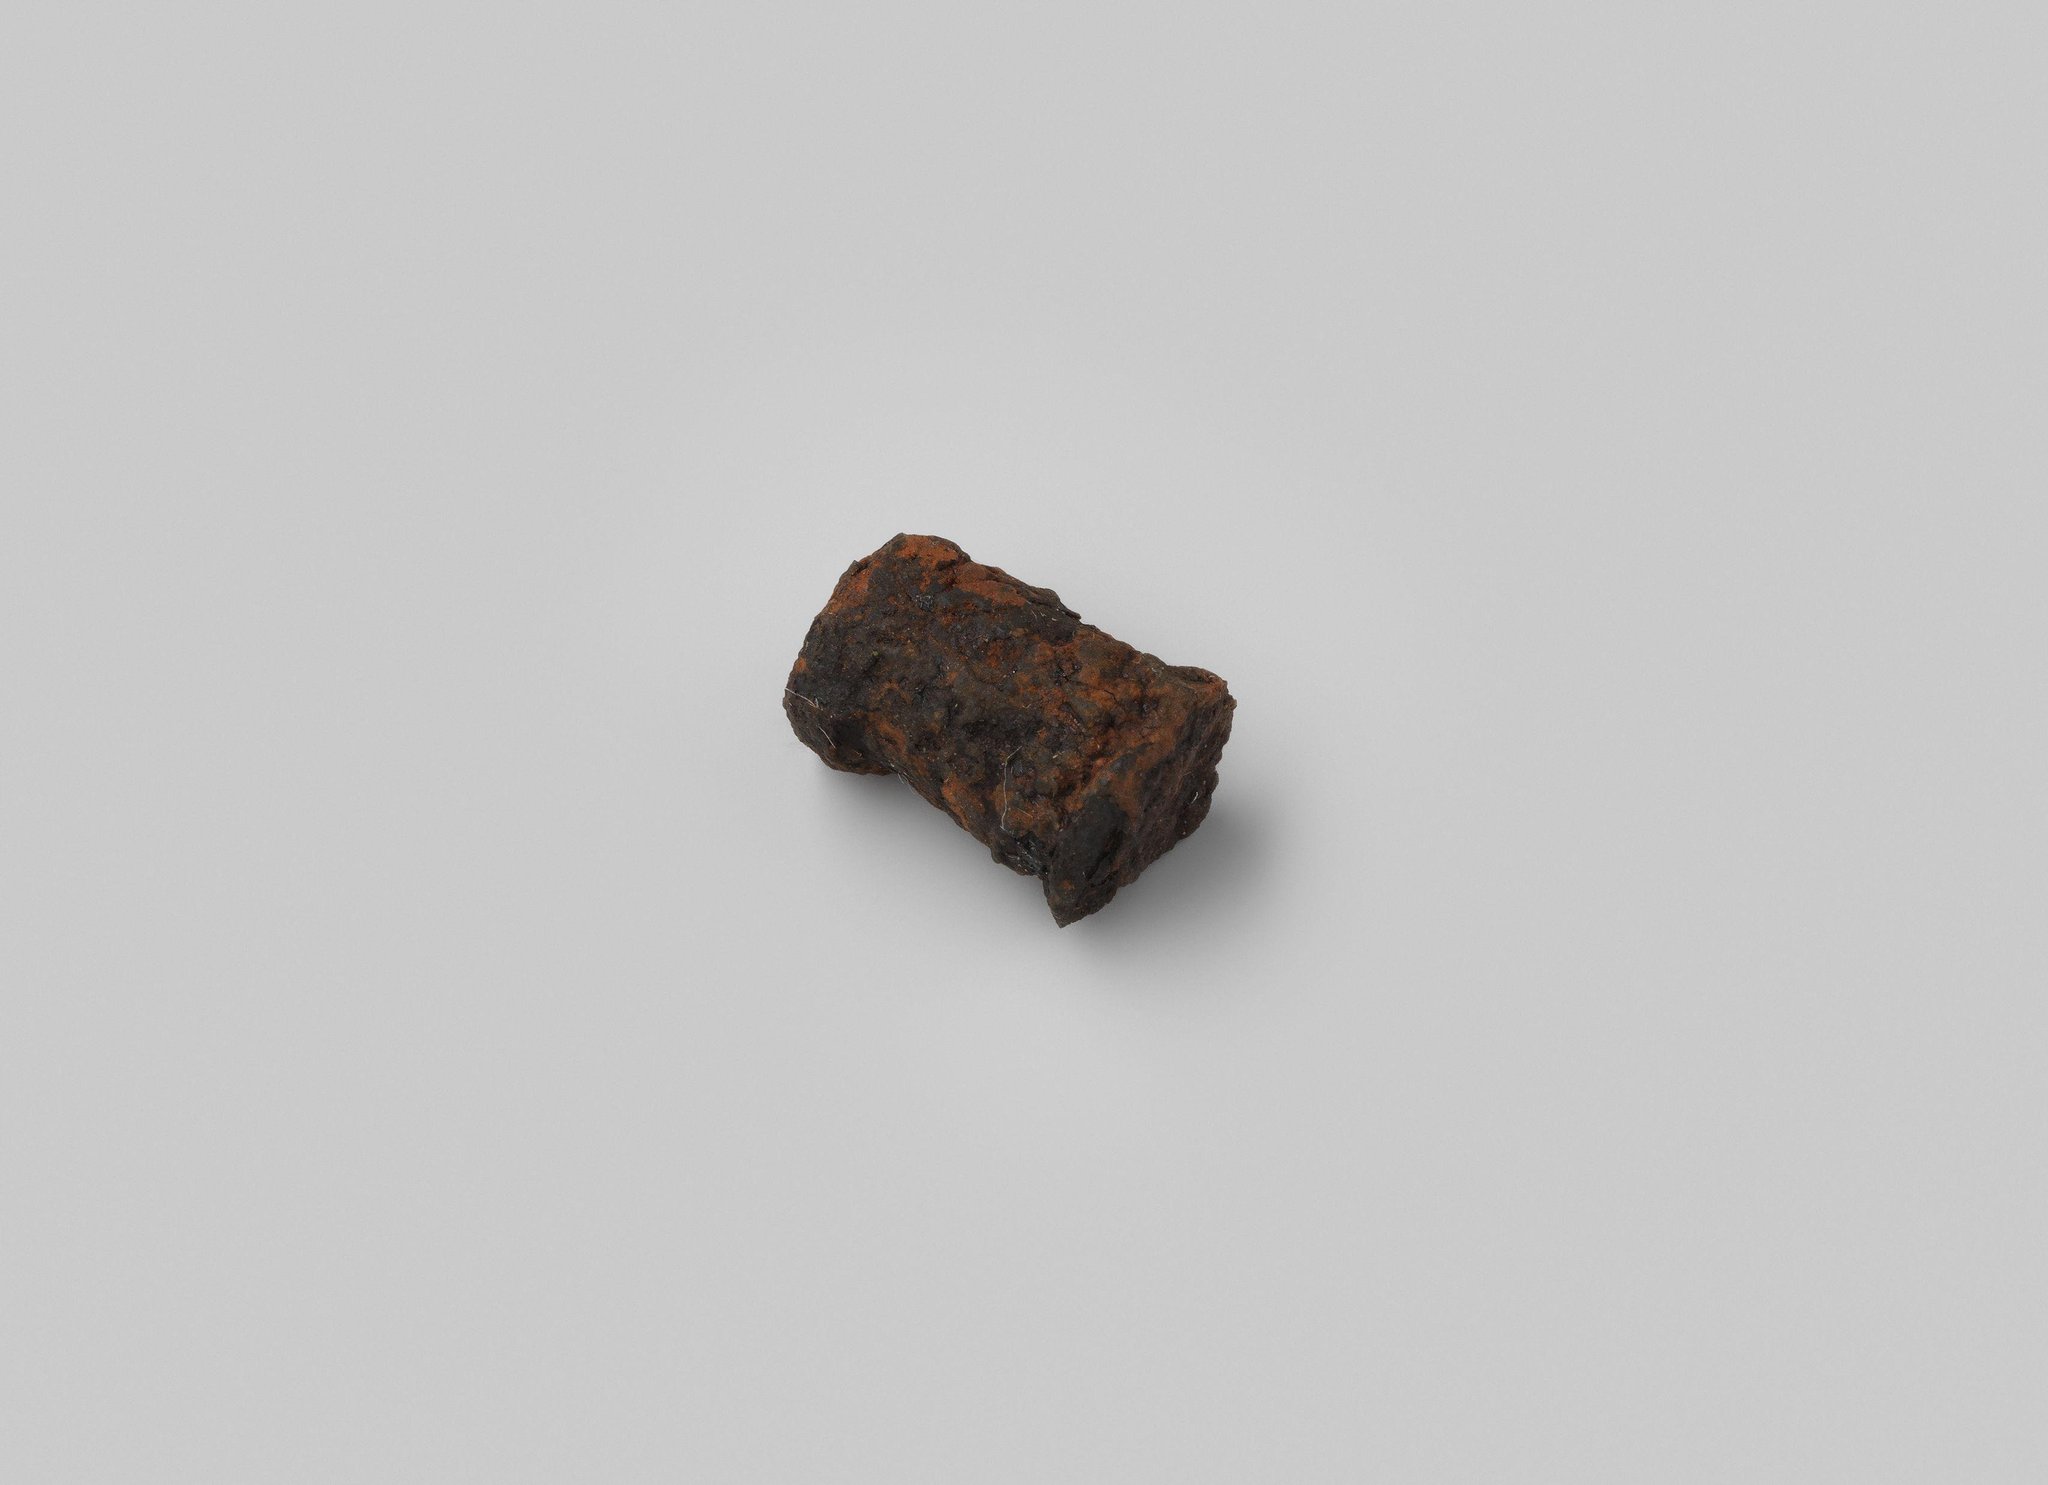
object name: rivet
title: Klinknagel afkomstig uit het wrak van de Oost-Indiëvaarder Hollandia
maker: Anonymous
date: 1700-1743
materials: iron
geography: netherlands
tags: verenigde oostindische compagnie, hollandia (schip)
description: Rivets; fragm of shaft, circular, eroded ends.